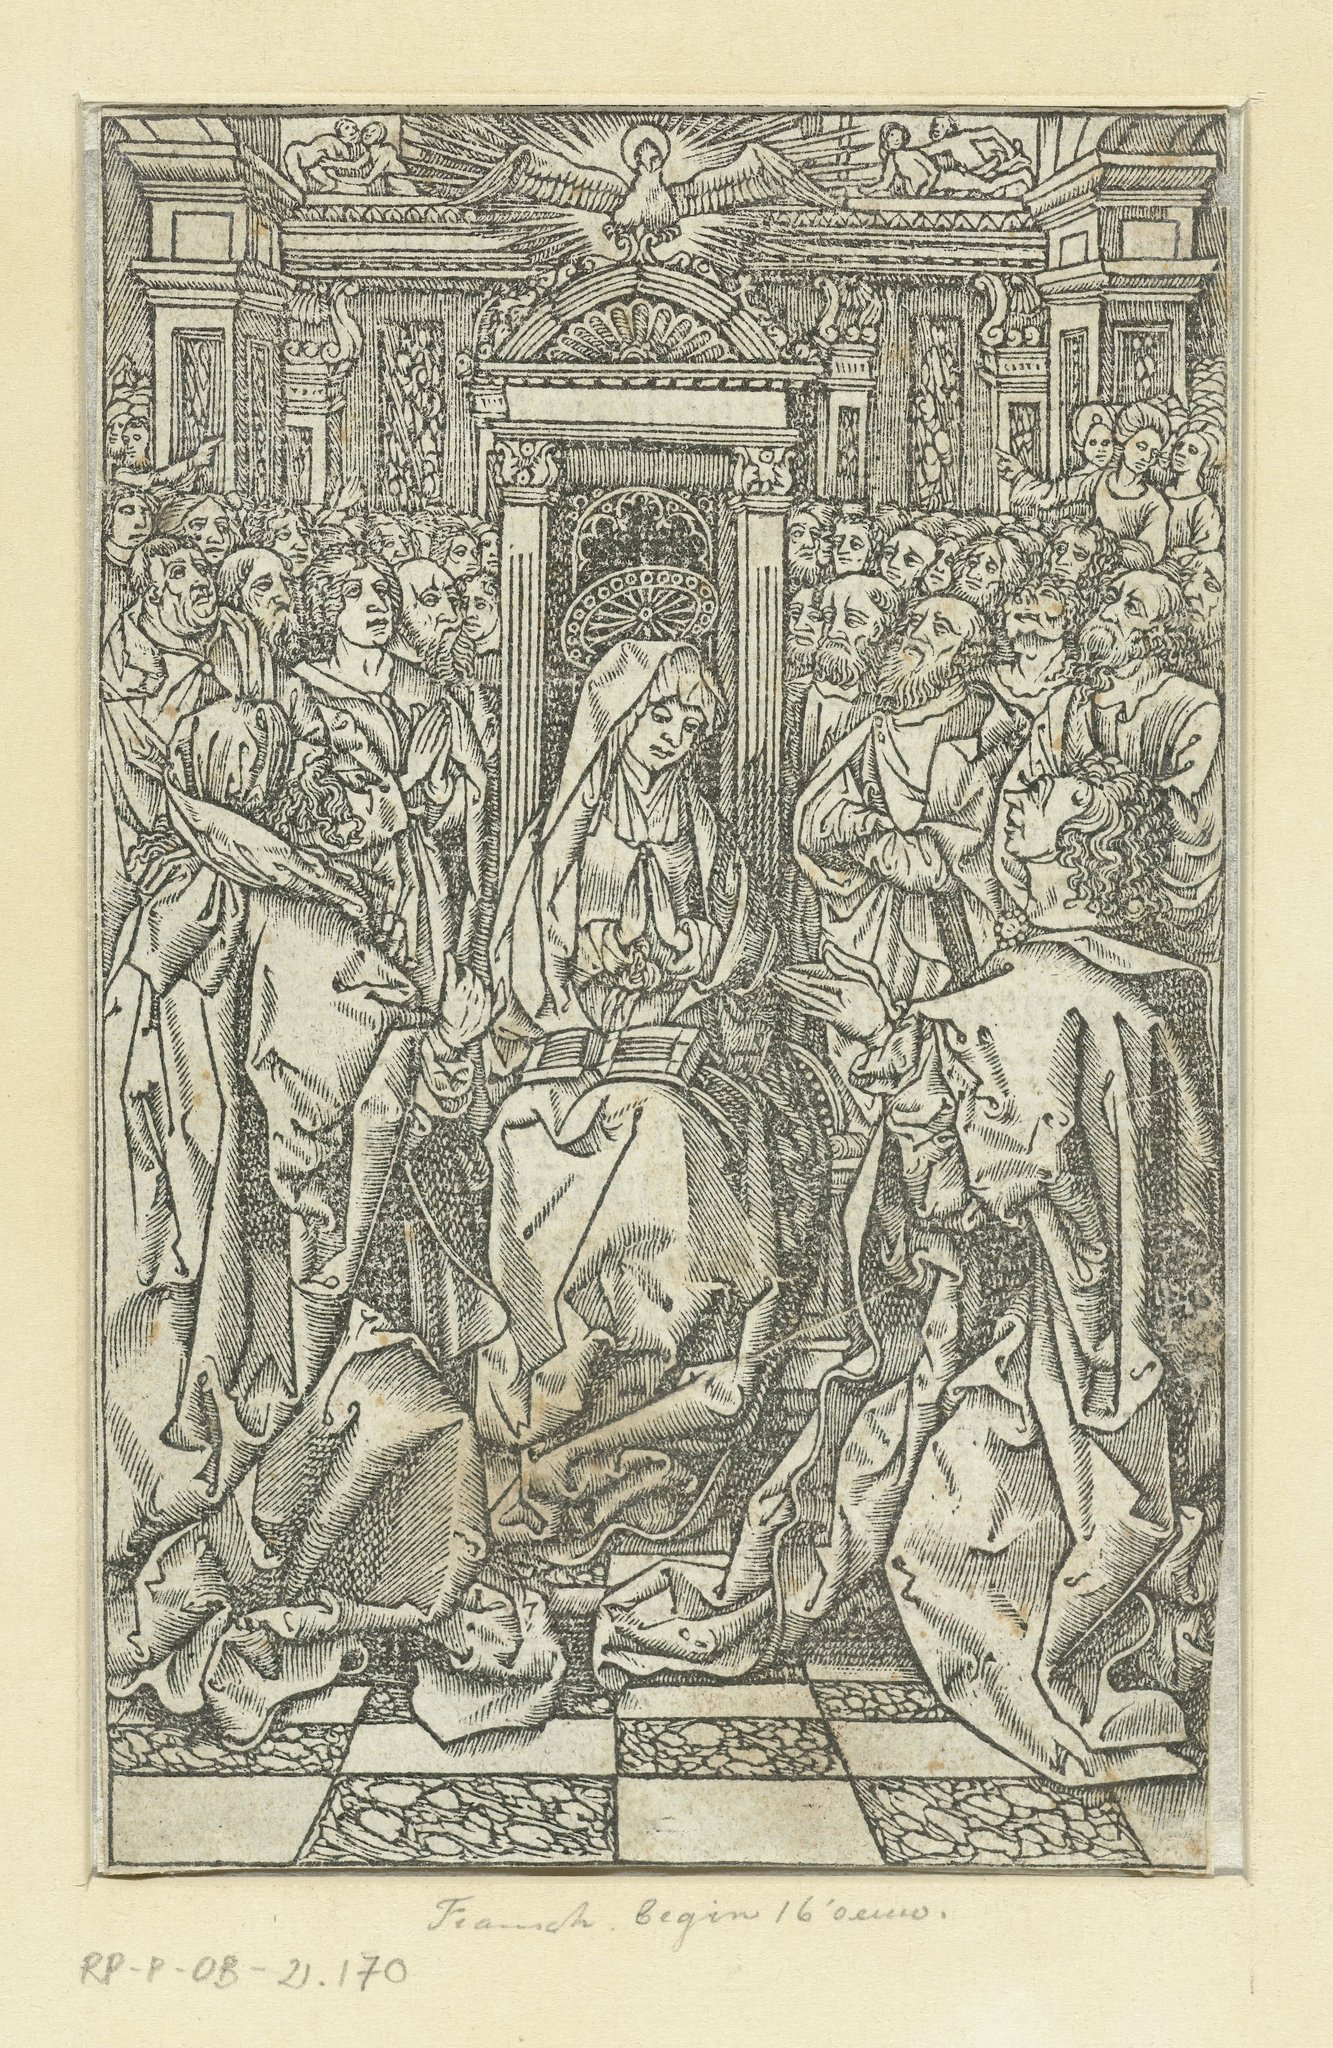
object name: print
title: Het leven van Maria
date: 1507-1508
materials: paper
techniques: woodcut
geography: paris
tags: mary as queen of the apostles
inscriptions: collector's mark: Lugt 240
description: Illustraties uit "Horae B. Mariae Virginis", uitgegeven door Thielman Kerver, Parijs 1508. Op verso tekst in het Latijn, gedrukt in zwart en rood. Langs de rand kleine voorstellingen (houtsneden). Botke, K.